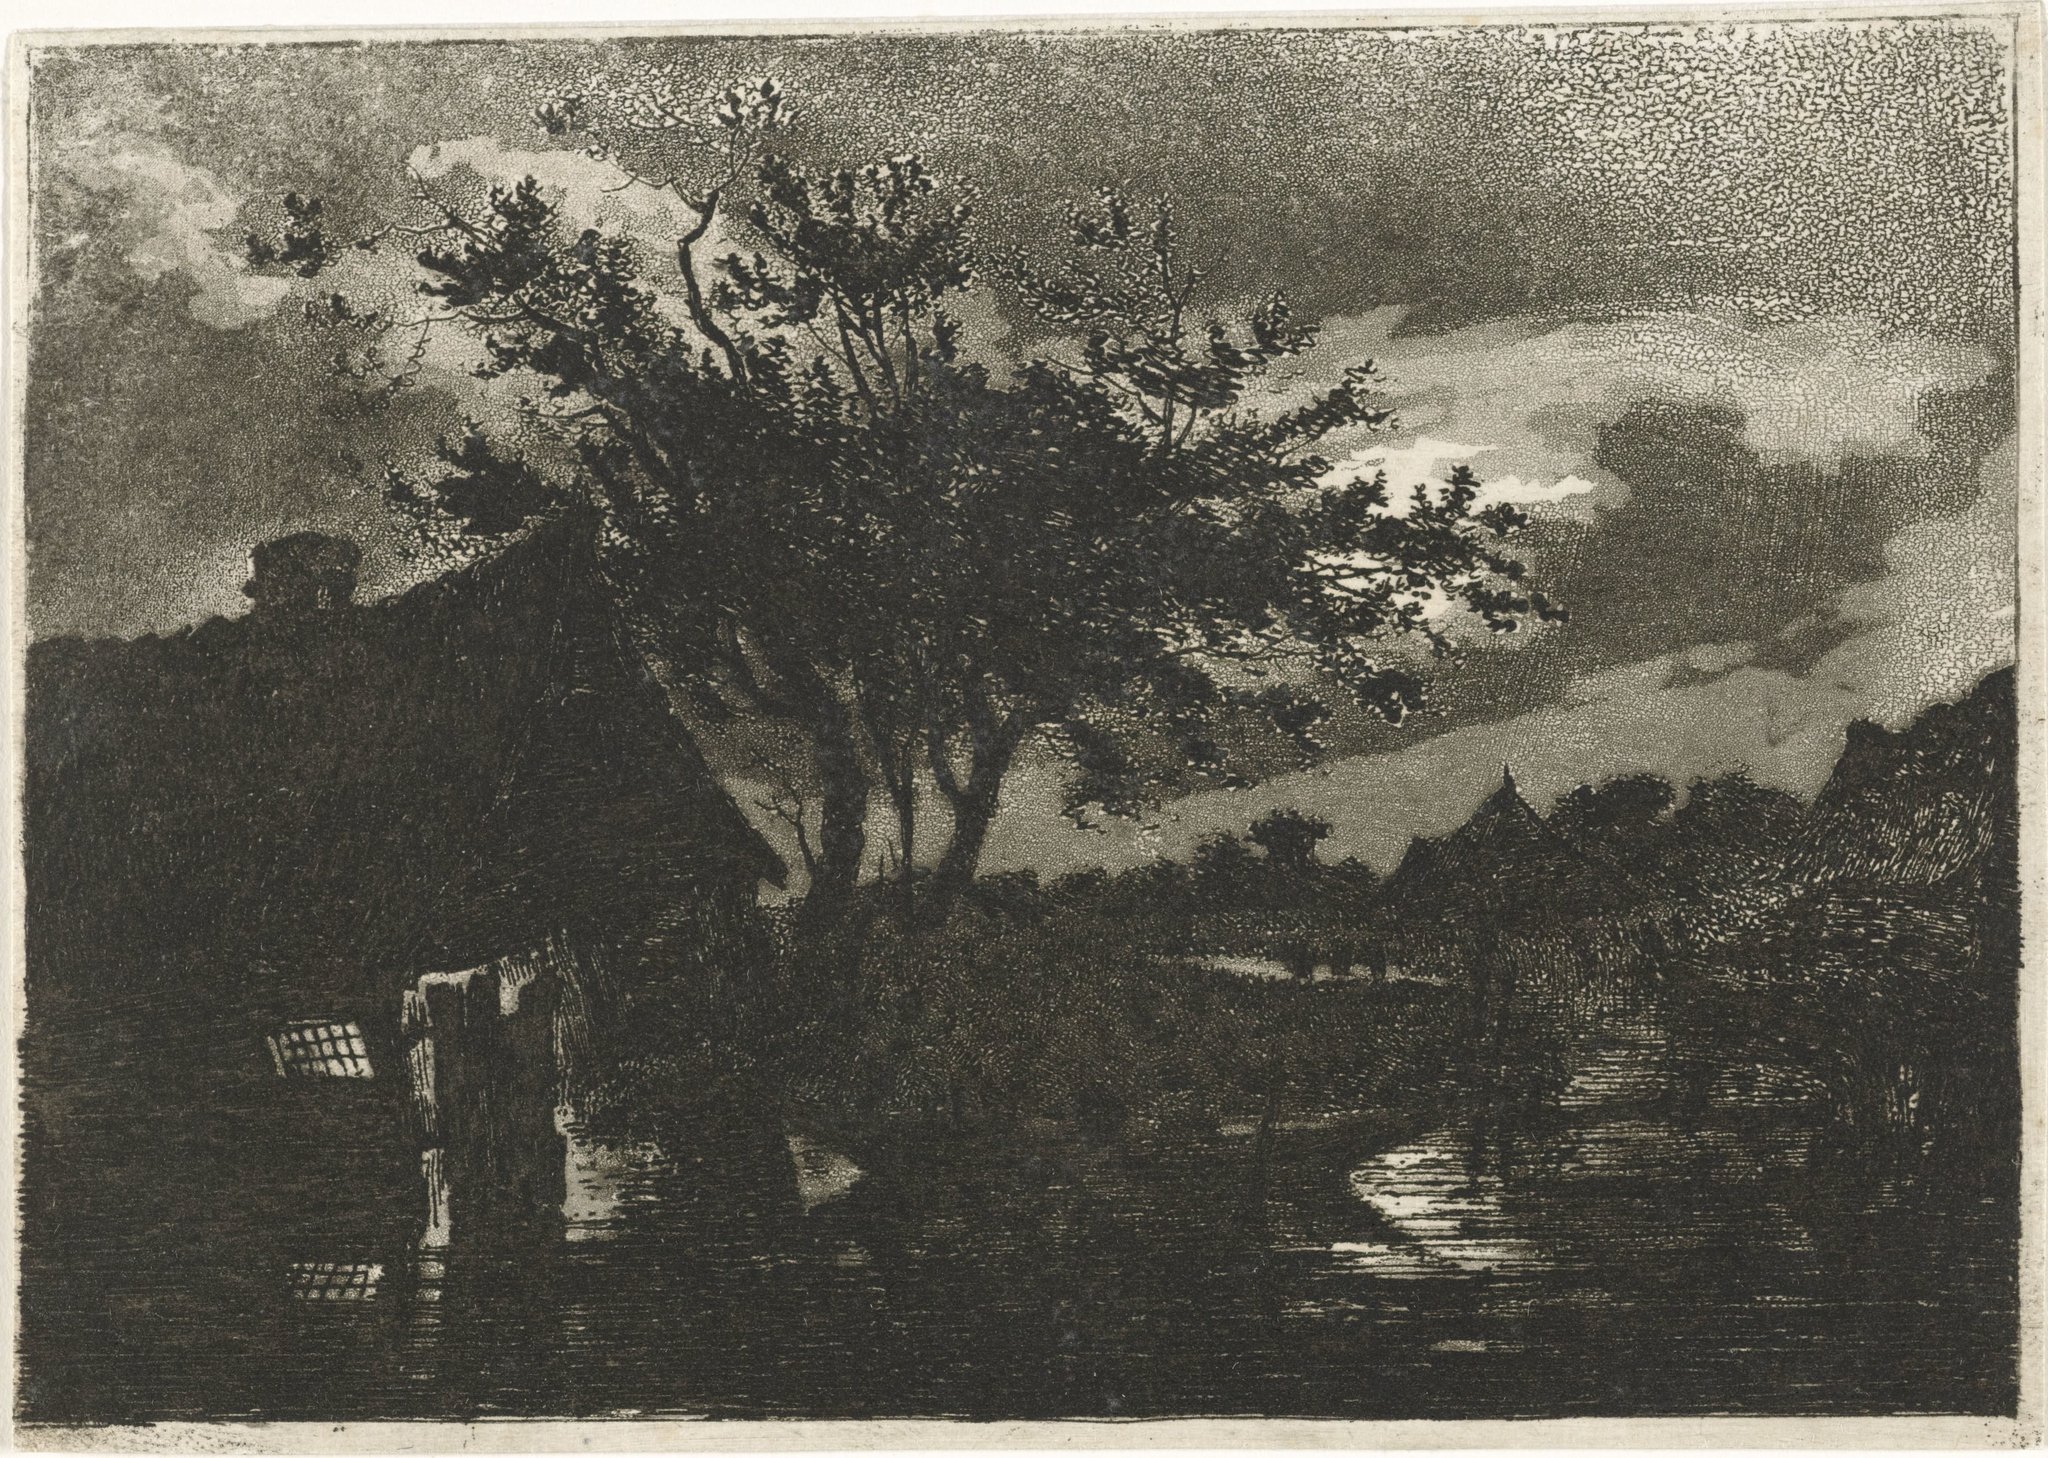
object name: print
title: Rivierlandschap met boerderij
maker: françois joseph pfeiffer (ii)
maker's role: draughtsman, print maker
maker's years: 1778-1835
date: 1793-1835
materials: paper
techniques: aquatint, etching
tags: rowing-boat, canoe, etc., farm or solitary house in landscape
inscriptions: collector's mark: Lugt 2228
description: Rivierlandschap met een vervallen boerderij, die gedeeltelijk in het water staat. Op de voorgrond twee mannen, die manden uit de boot aan wal brengen.